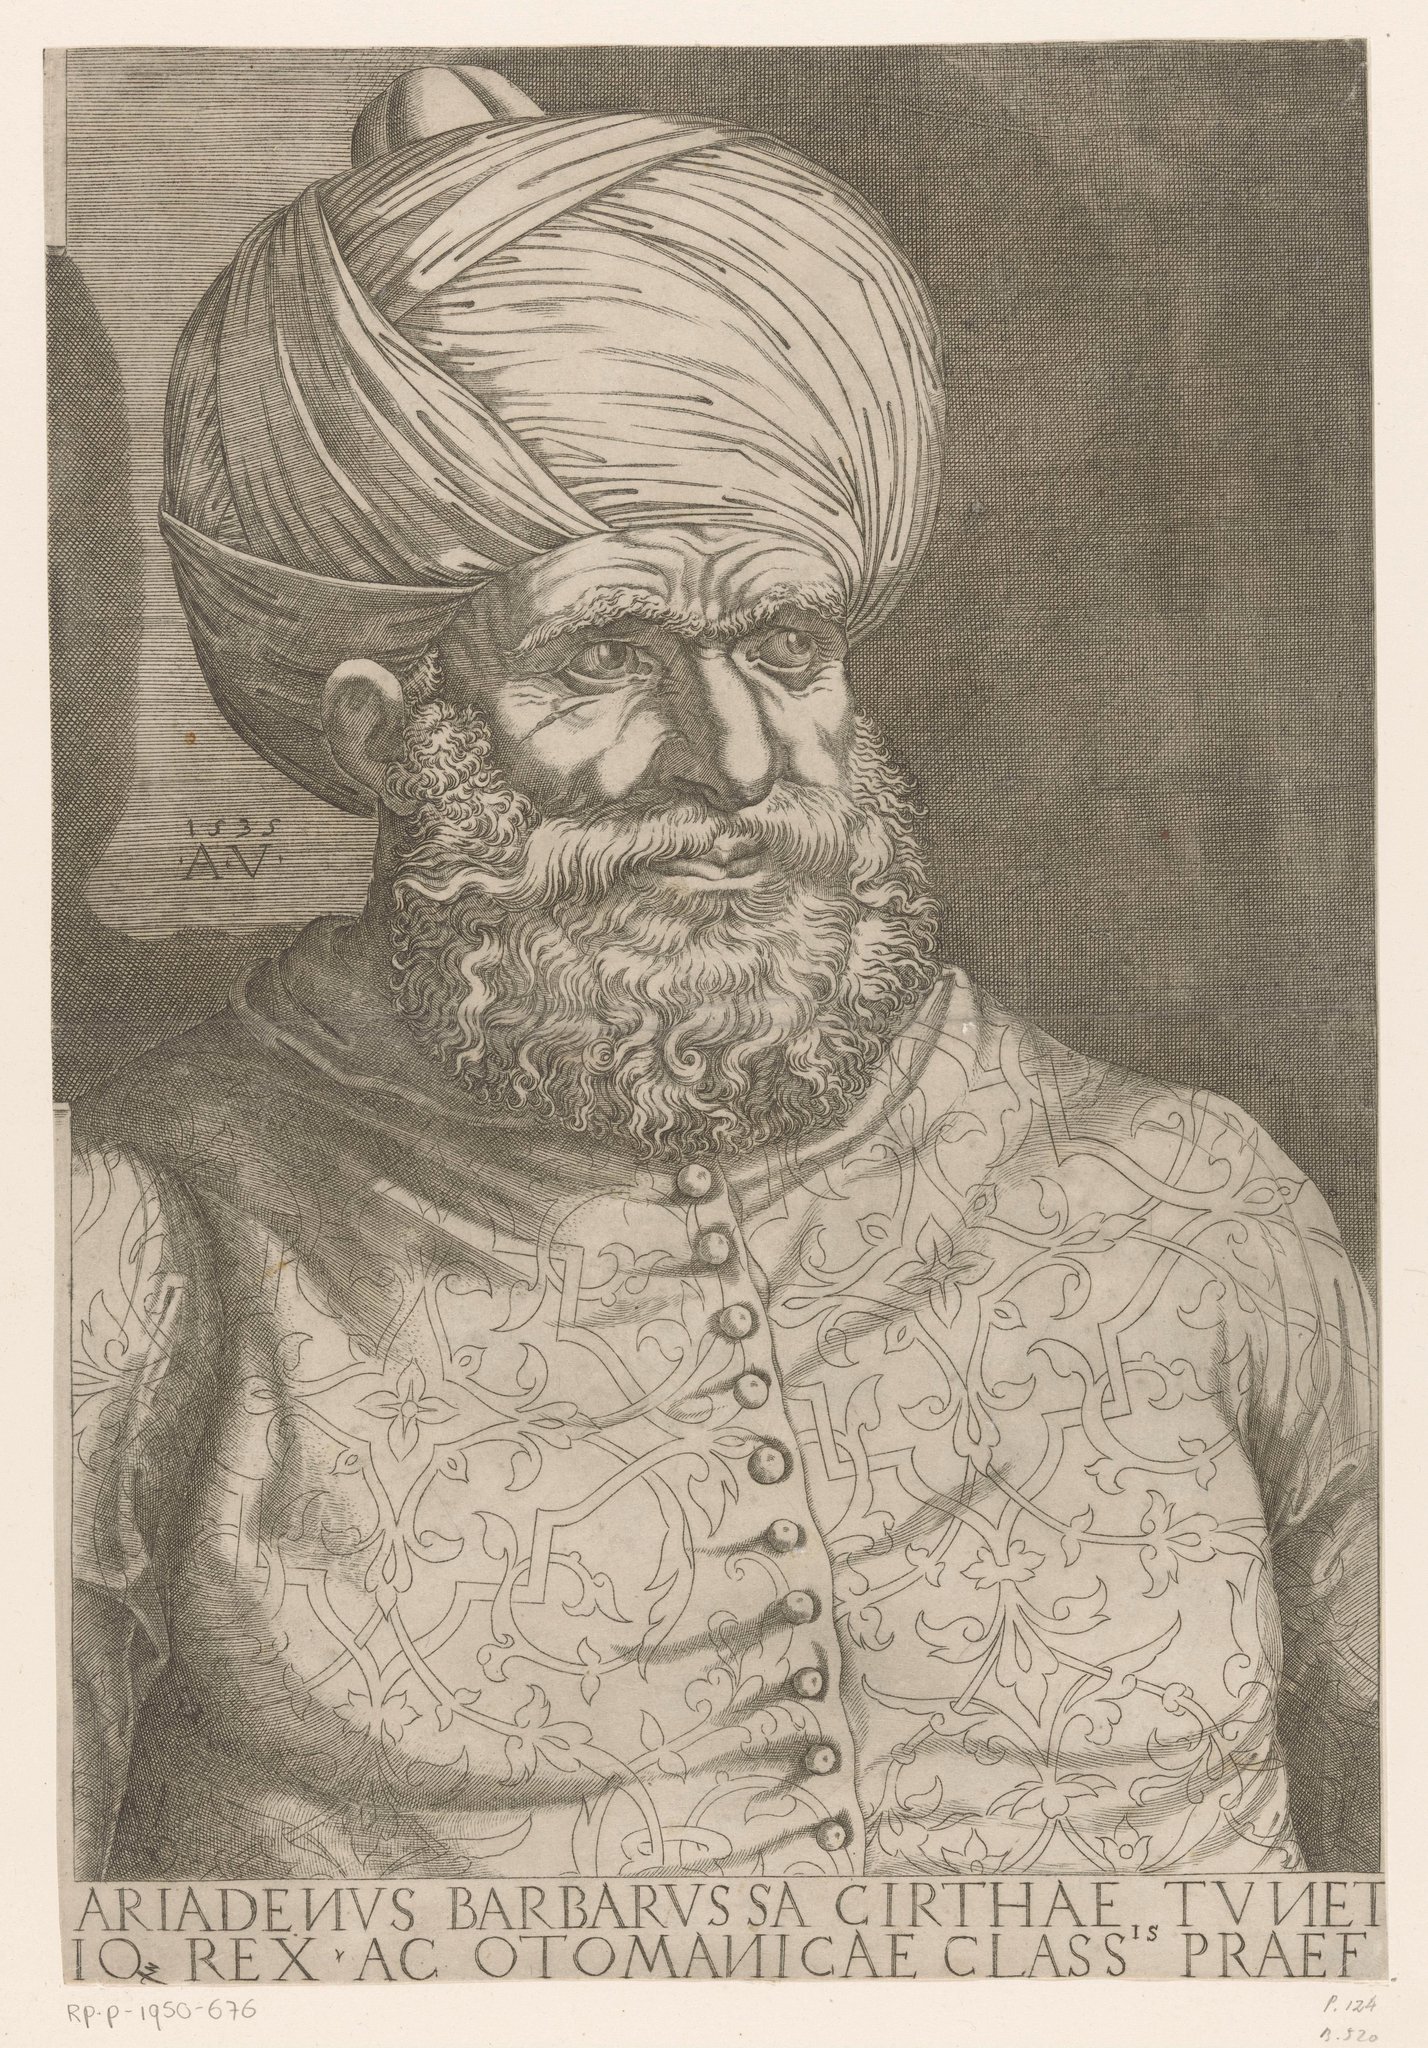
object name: print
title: Khair ad-Din Barbarossa Süleyman I & Khair ad-Din Barbarossa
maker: agostino veneziano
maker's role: draughtsman, painter, print maker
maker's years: 1490-1536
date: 1535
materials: paper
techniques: engraving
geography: italy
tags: capuche, historical persons, head-gear: turban, ruler, sovereign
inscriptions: collector's mark: Lugt 2228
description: By order of Sultan Suleiman I, Admiral Khair ad-Din Barbarossa equipped a vast fleet with which he captured Tunis in 1534. Charles V came to the rescue of the ousted Tunisian king with a large army. This conquest was followed with great interest and portraits of the most important leaders soon became available throughout Europe, such as this large engraving of the Ottoman admiral.